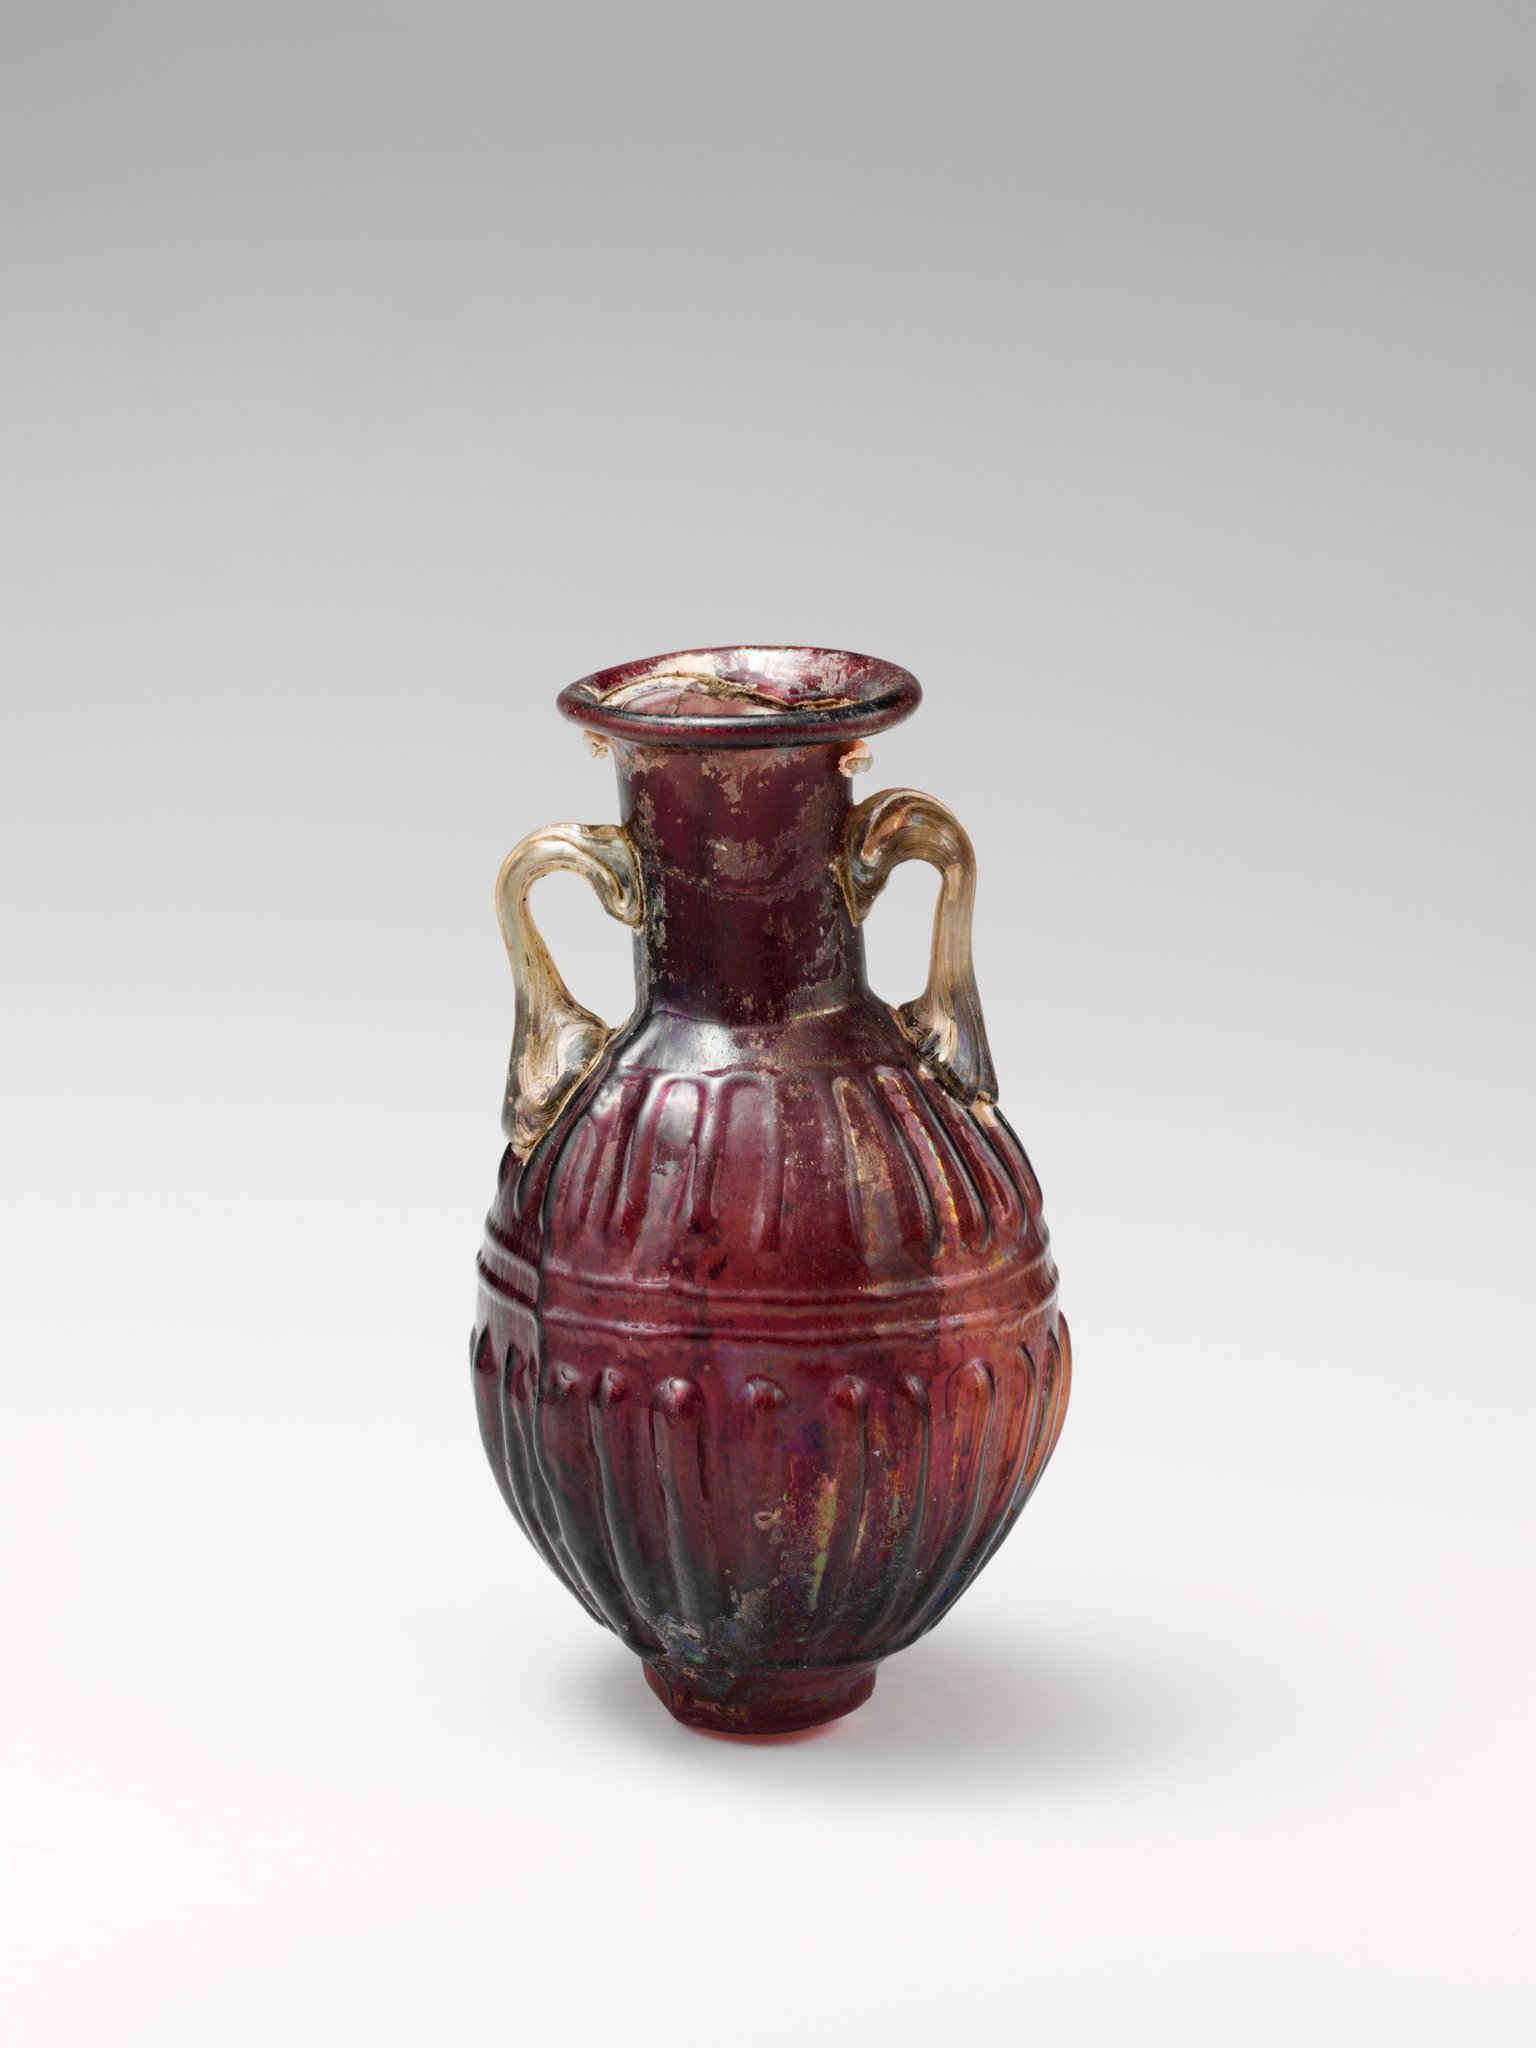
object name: amphoriskos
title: Glass amphoriskos (perfume flask)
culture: roman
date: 1-100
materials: glass